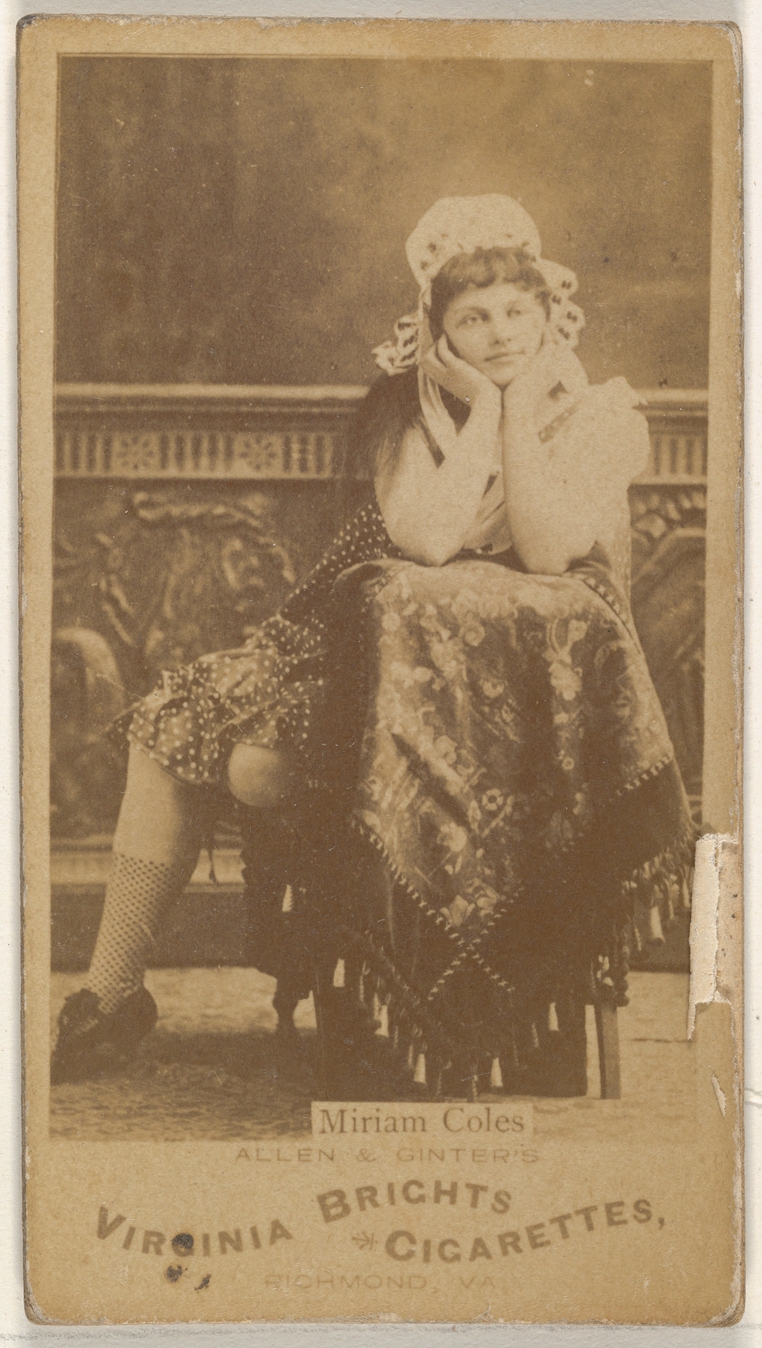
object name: photograph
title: Miriam Coles, from the Actors and Actresses series (N45, Type 1) for Virginia Brights Cigarettes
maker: allen & ginter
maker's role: publisher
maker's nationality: american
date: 1888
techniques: albumen silver print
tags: portraits,women,actresses